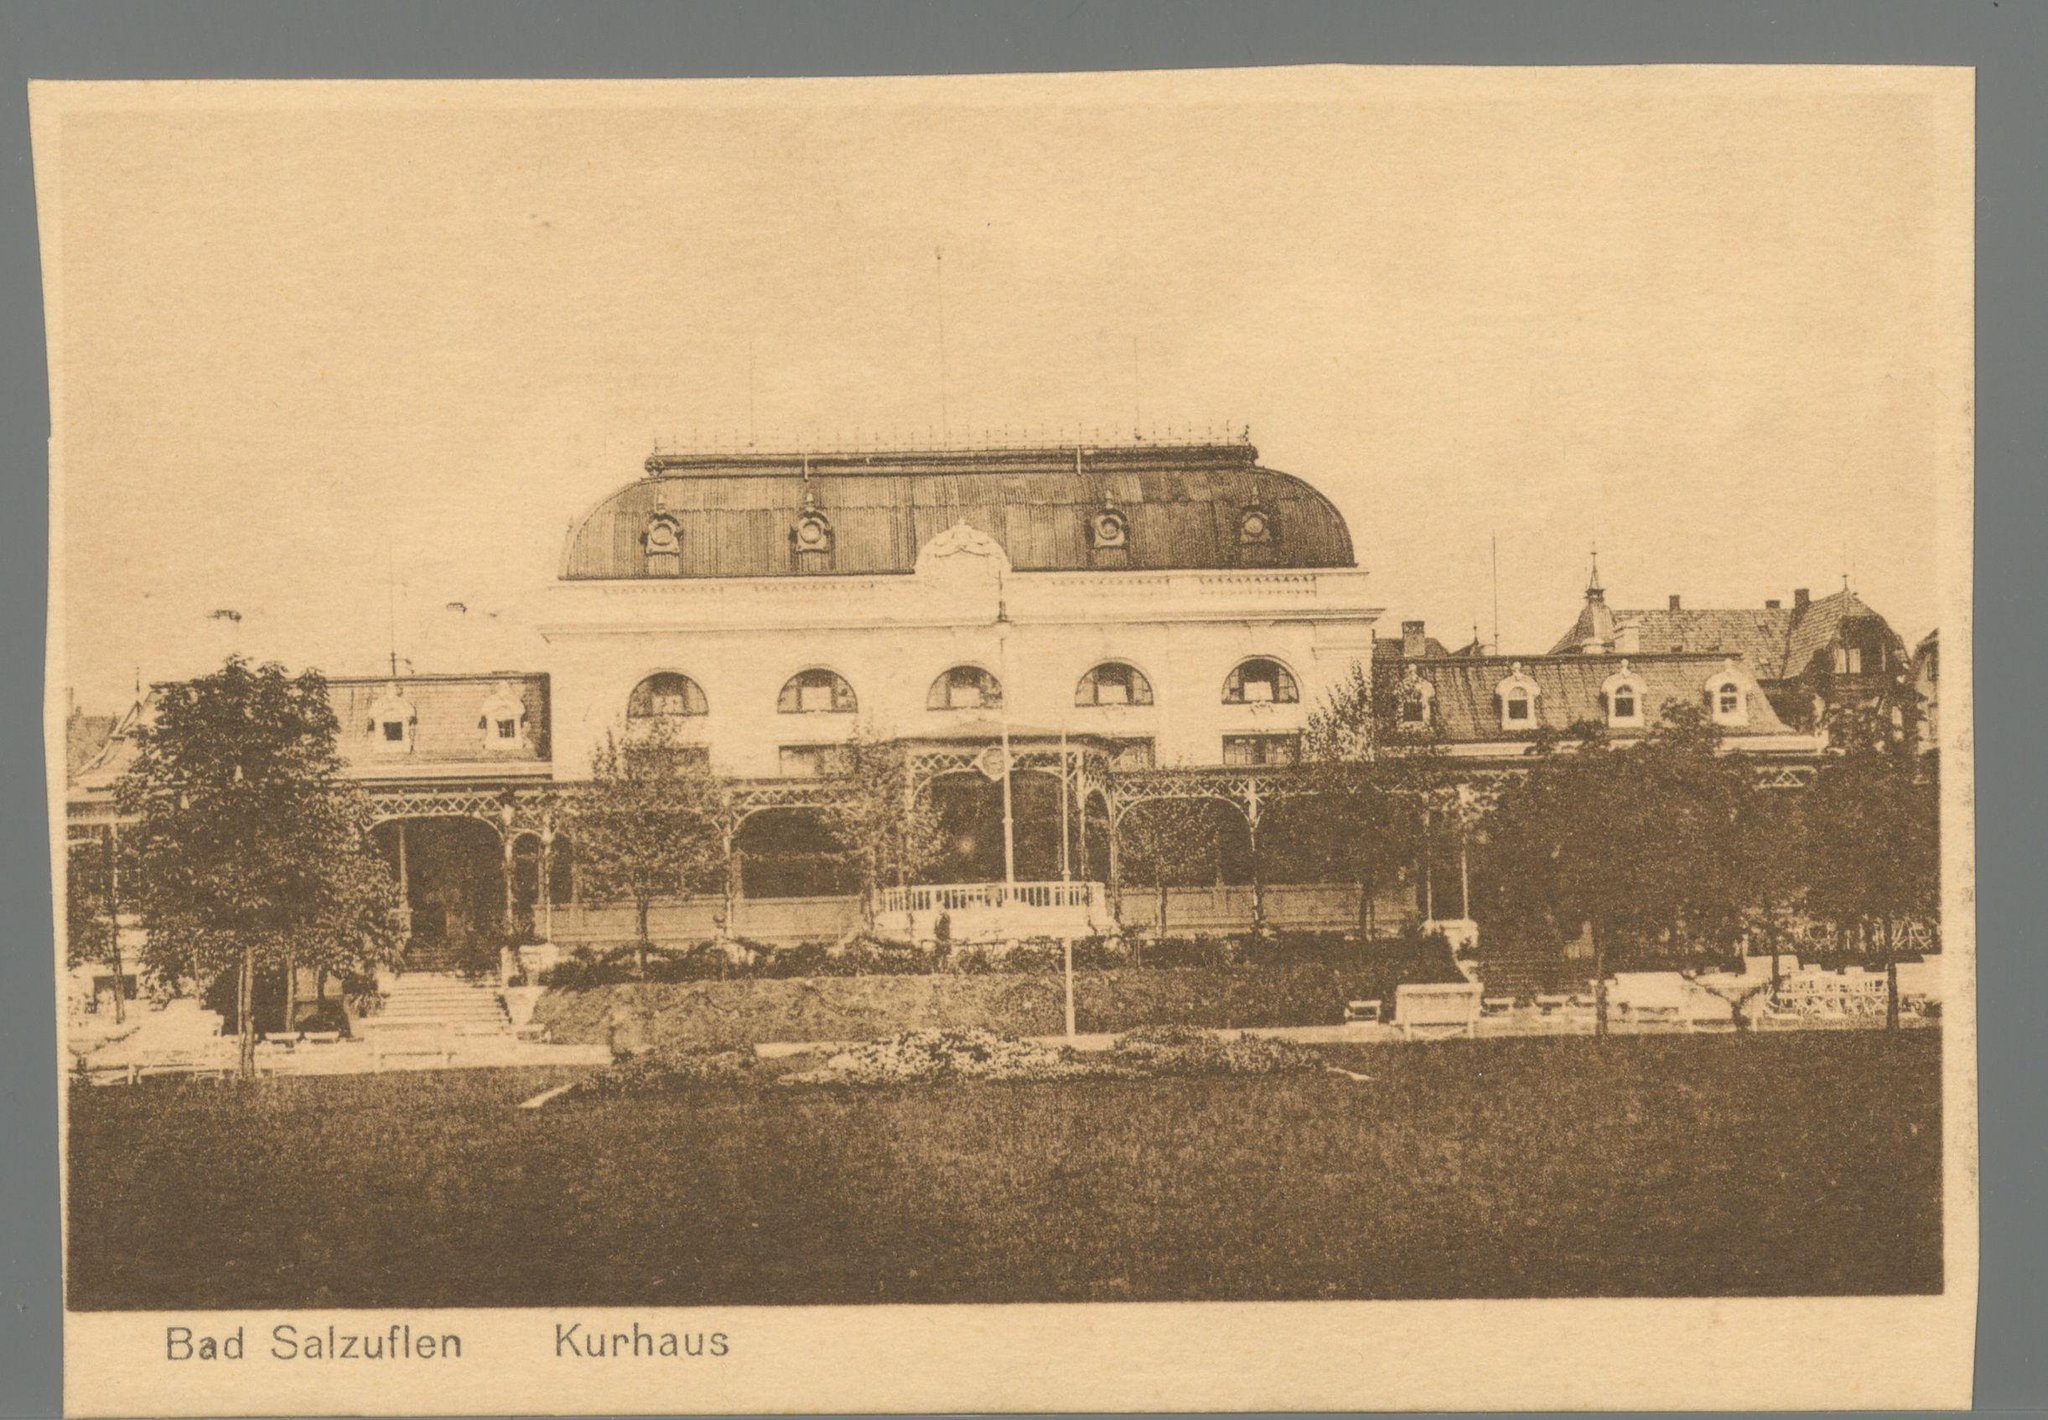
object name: photomechanical print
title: Bad Salzuflen. Kurhaus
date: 1905-1930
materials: cardboard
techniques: photograph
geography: bad salzuflen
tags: watering-place, spa